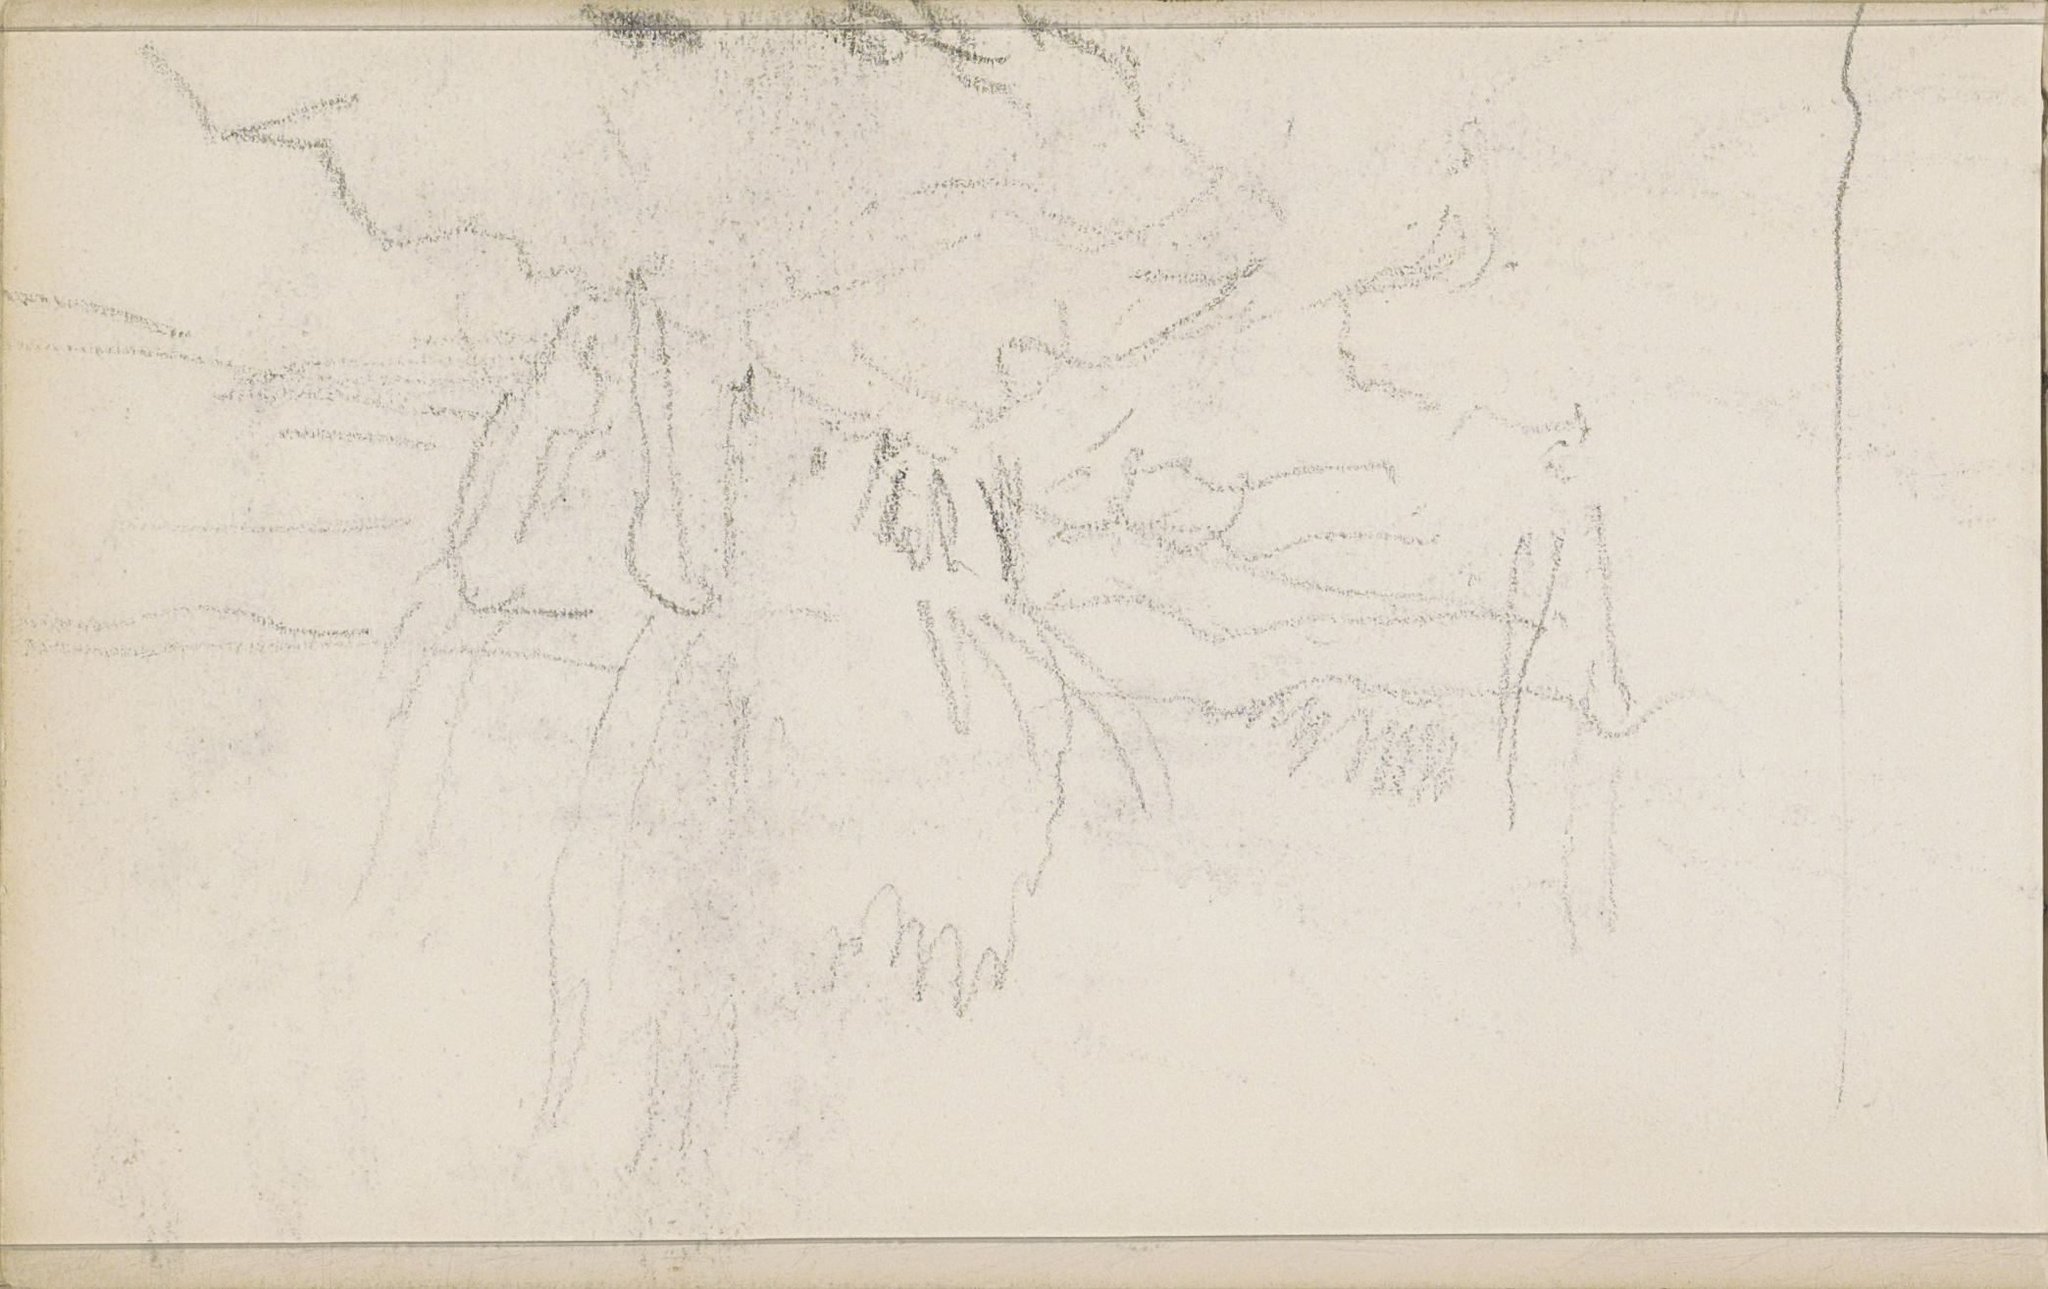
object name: sketchbook leaf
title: Landschap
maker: anton mauve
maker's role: draughtsman, painter, print maker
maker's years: 1838-1888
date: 1848-1888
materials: paper, pencil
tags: landscapes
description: Blad 12 verso uit een schetsboek met 44 bladen.